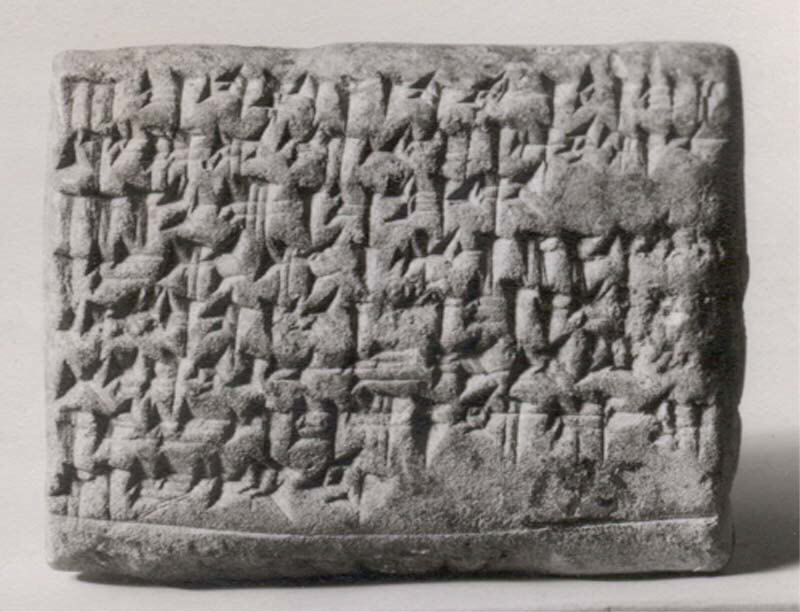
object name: cuneiform tablet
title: Cuneiform tablet: promissory note for silver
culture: assyrian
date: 652 BCE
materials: clay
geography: mesopotamia